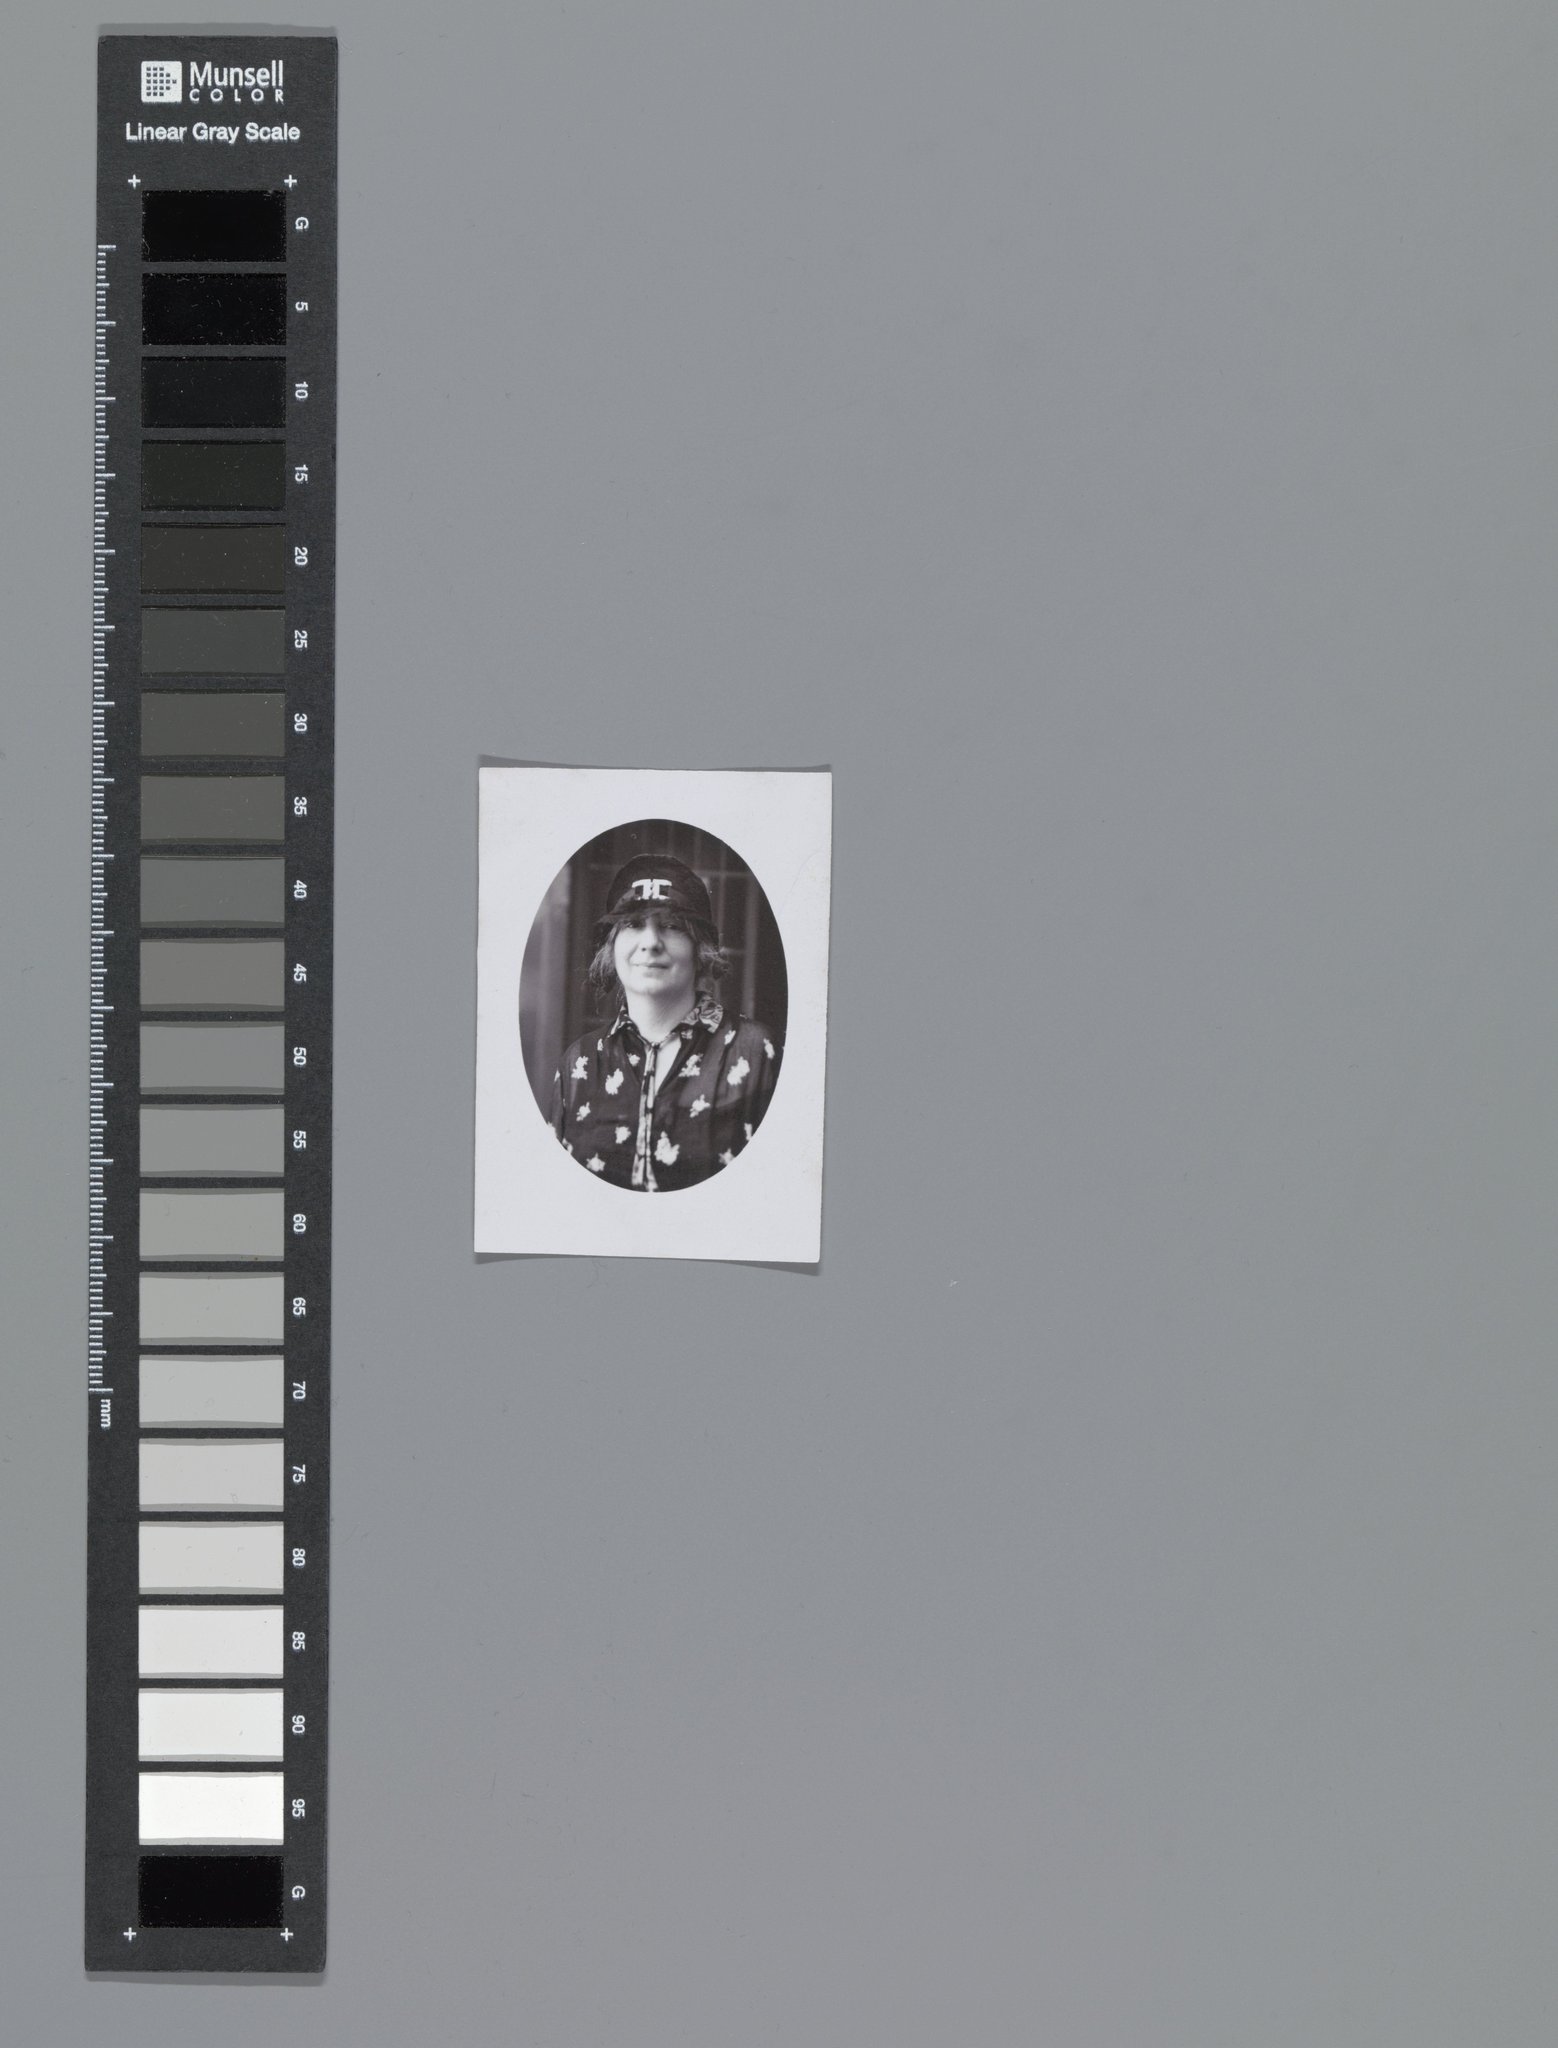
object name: passport photograph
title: Pasfoto van Marie Witsen-Schorr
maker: Anonymous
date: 1860-1915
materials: paper, photographic support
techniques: gelatin silver print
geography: netherlands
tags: amsterdam, augusta maria agnes witsen-schorr